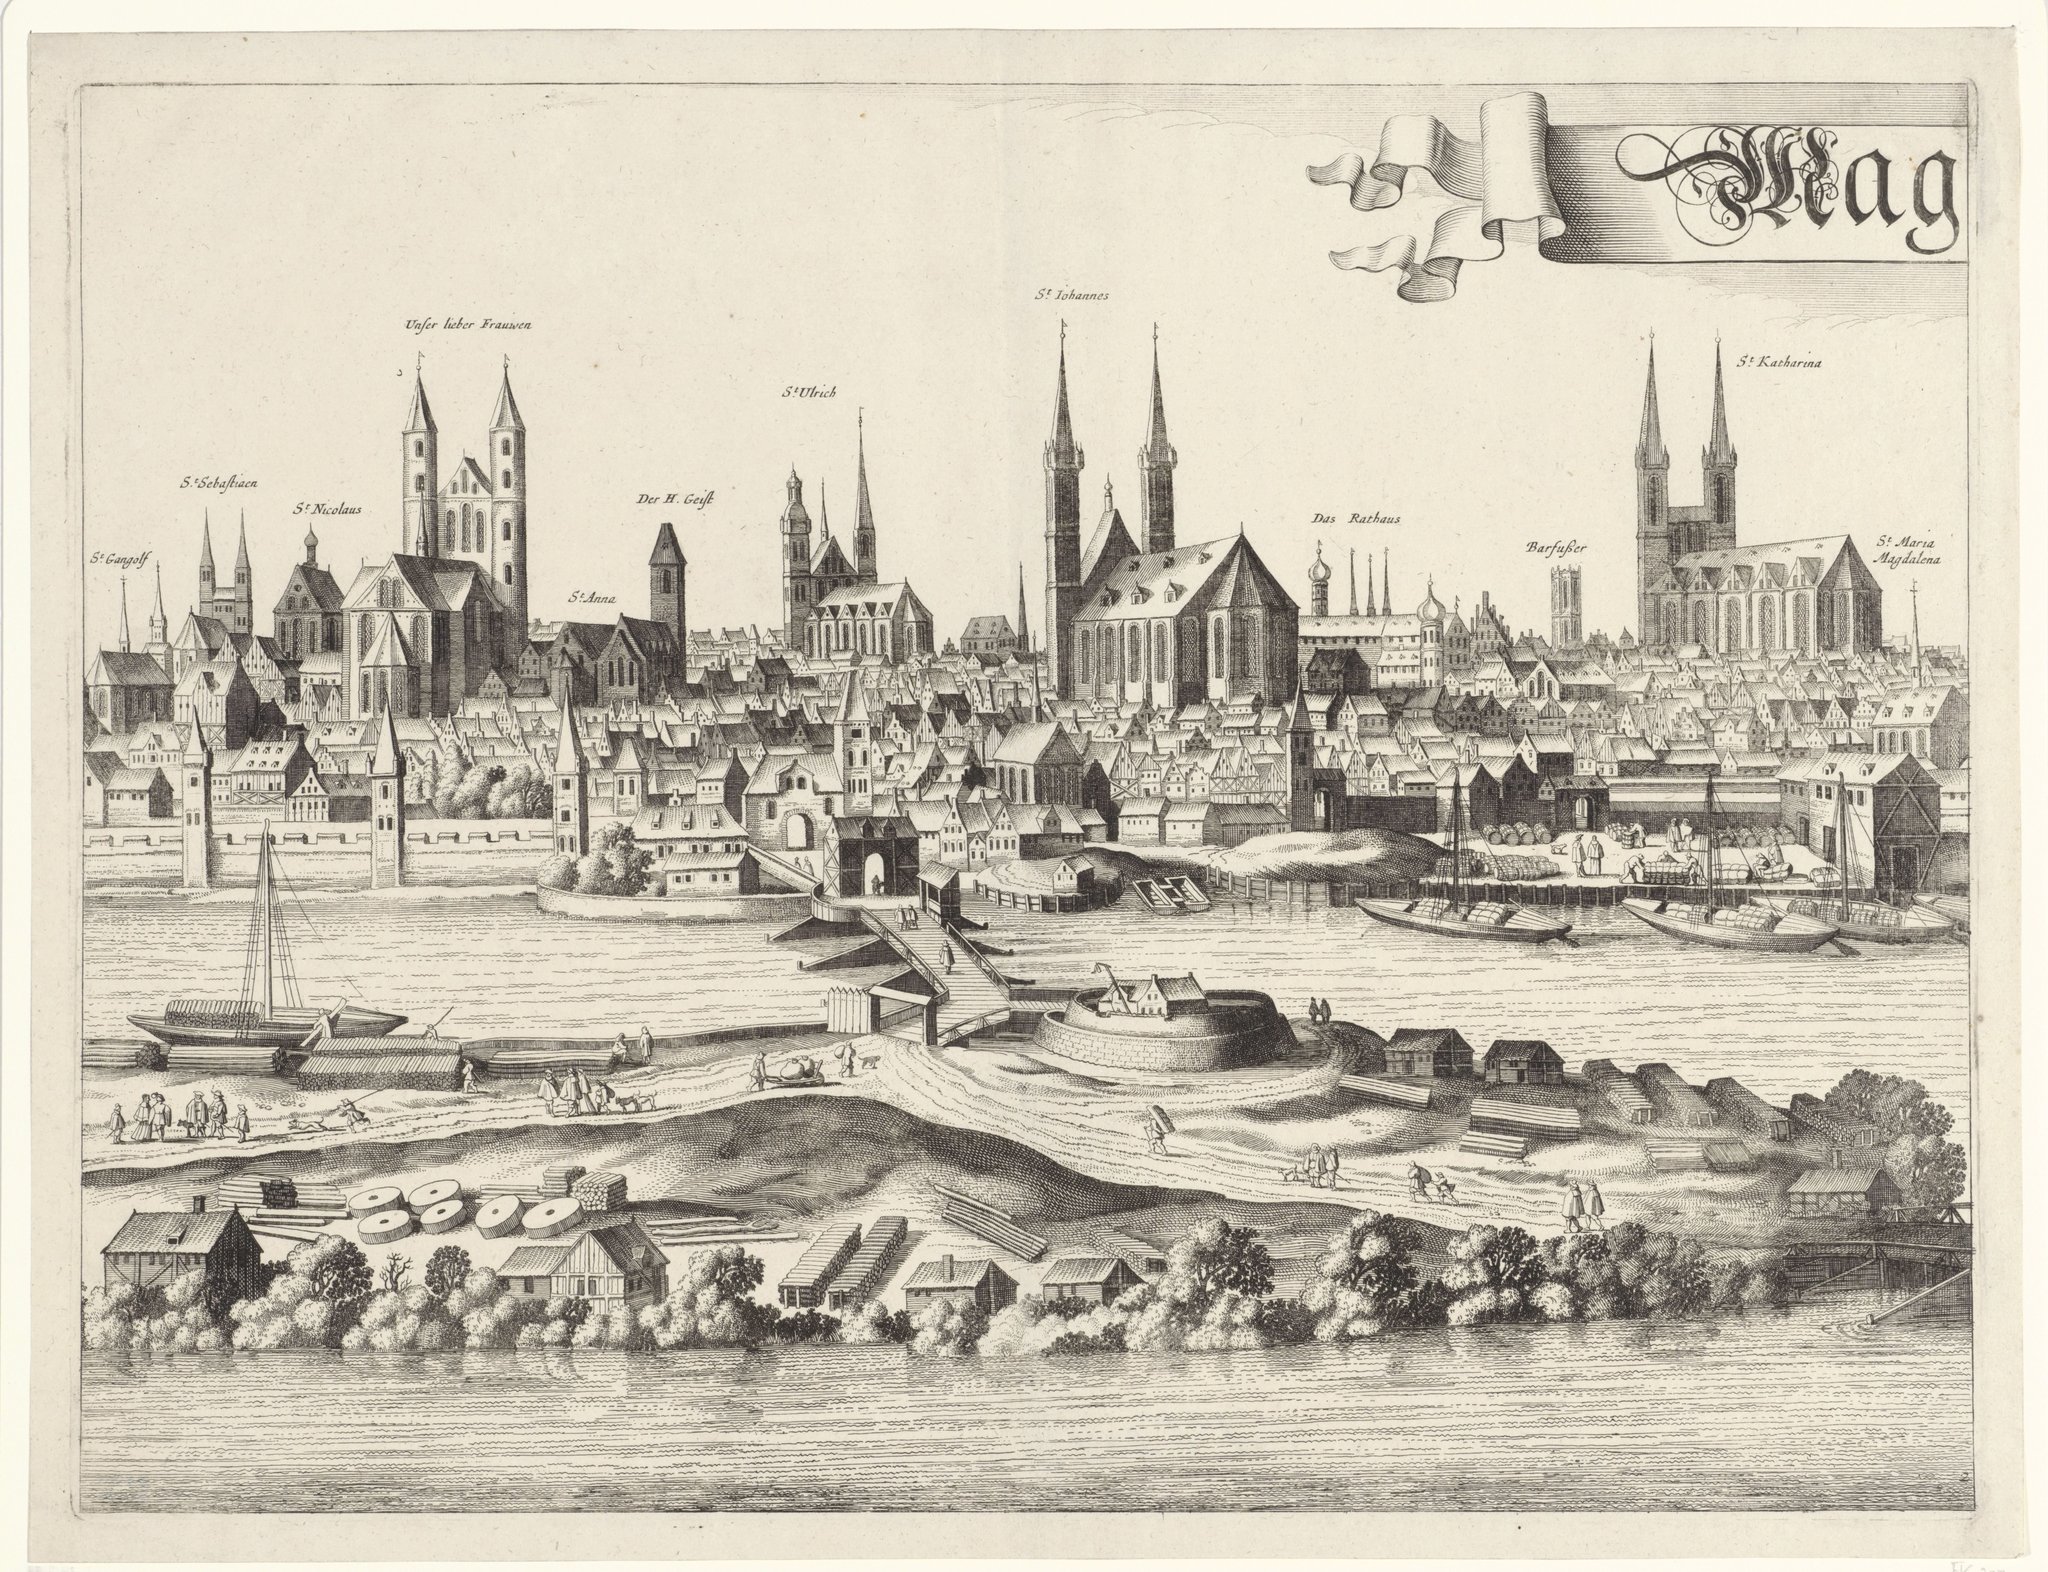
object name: print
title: Gezicht op Maagdenburg, linker middenblad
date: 1637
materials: paper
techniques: etching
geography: amsterdam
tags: prospect of village, silhouette of village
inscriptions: collector's mark: Lugt 2165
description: Panorama van Maagdenburg, gezien van de overzijde van de Elbe naar het westen. In het midden de Sint-Johanneskerk.